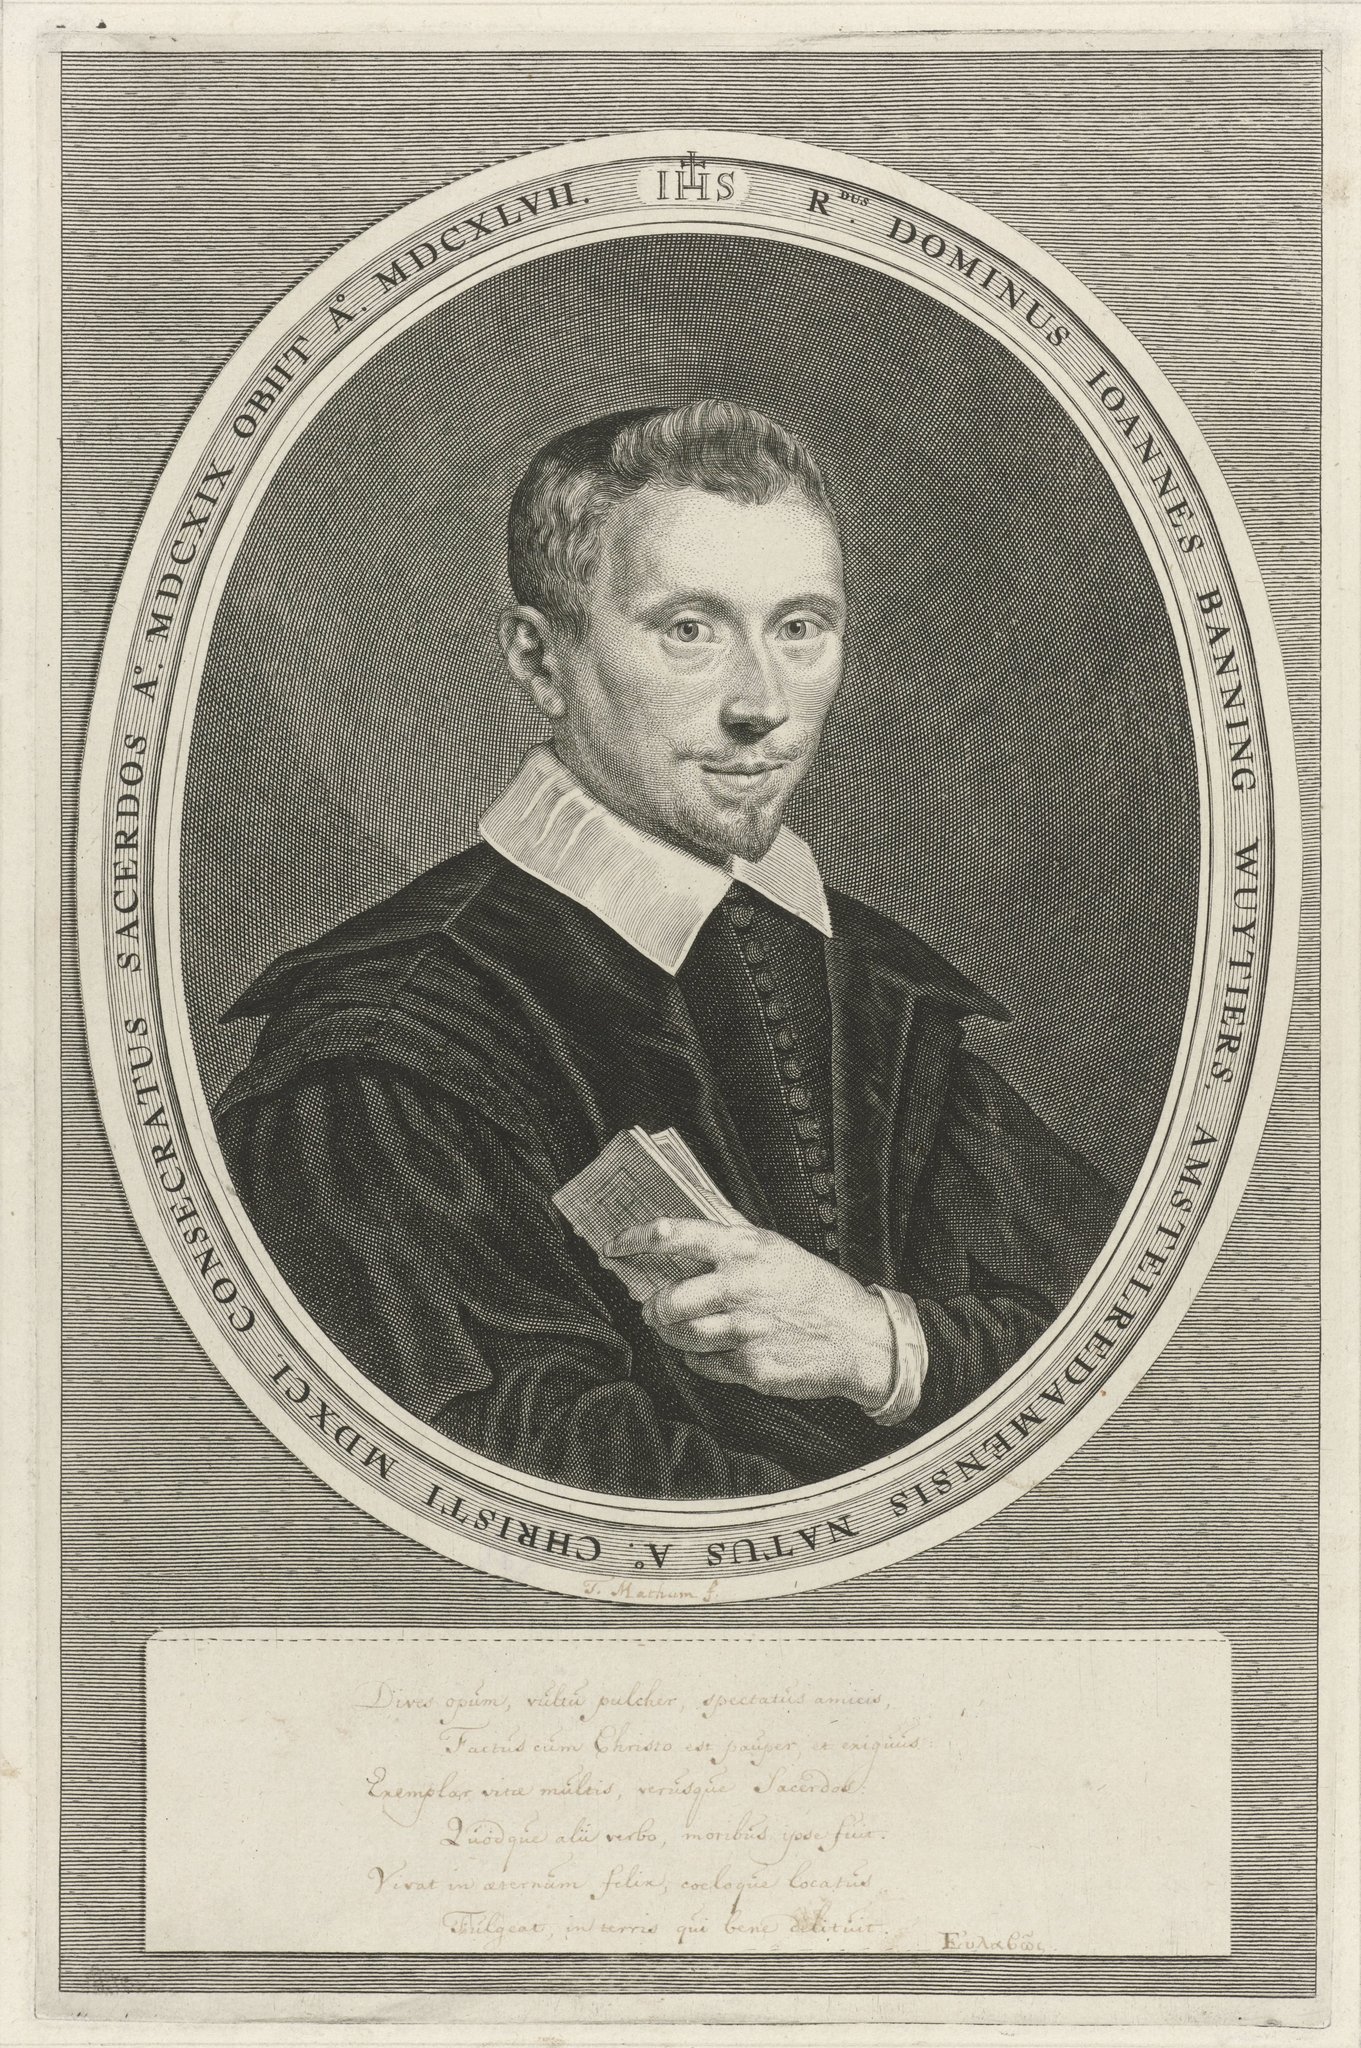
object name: print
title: Portret van Joannes Banning Wuytiers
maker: theodor matham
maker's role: draughtsman, print maker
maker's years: 1605-1676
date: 1647-1676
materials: paper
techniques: engraving, pen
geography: northern netherlands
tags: joannes banning wuytiers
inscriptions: collector's mark: Lugt 240, poem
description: Portret van Joannes Banning Wuytiers, pastoor te Amsterdam.